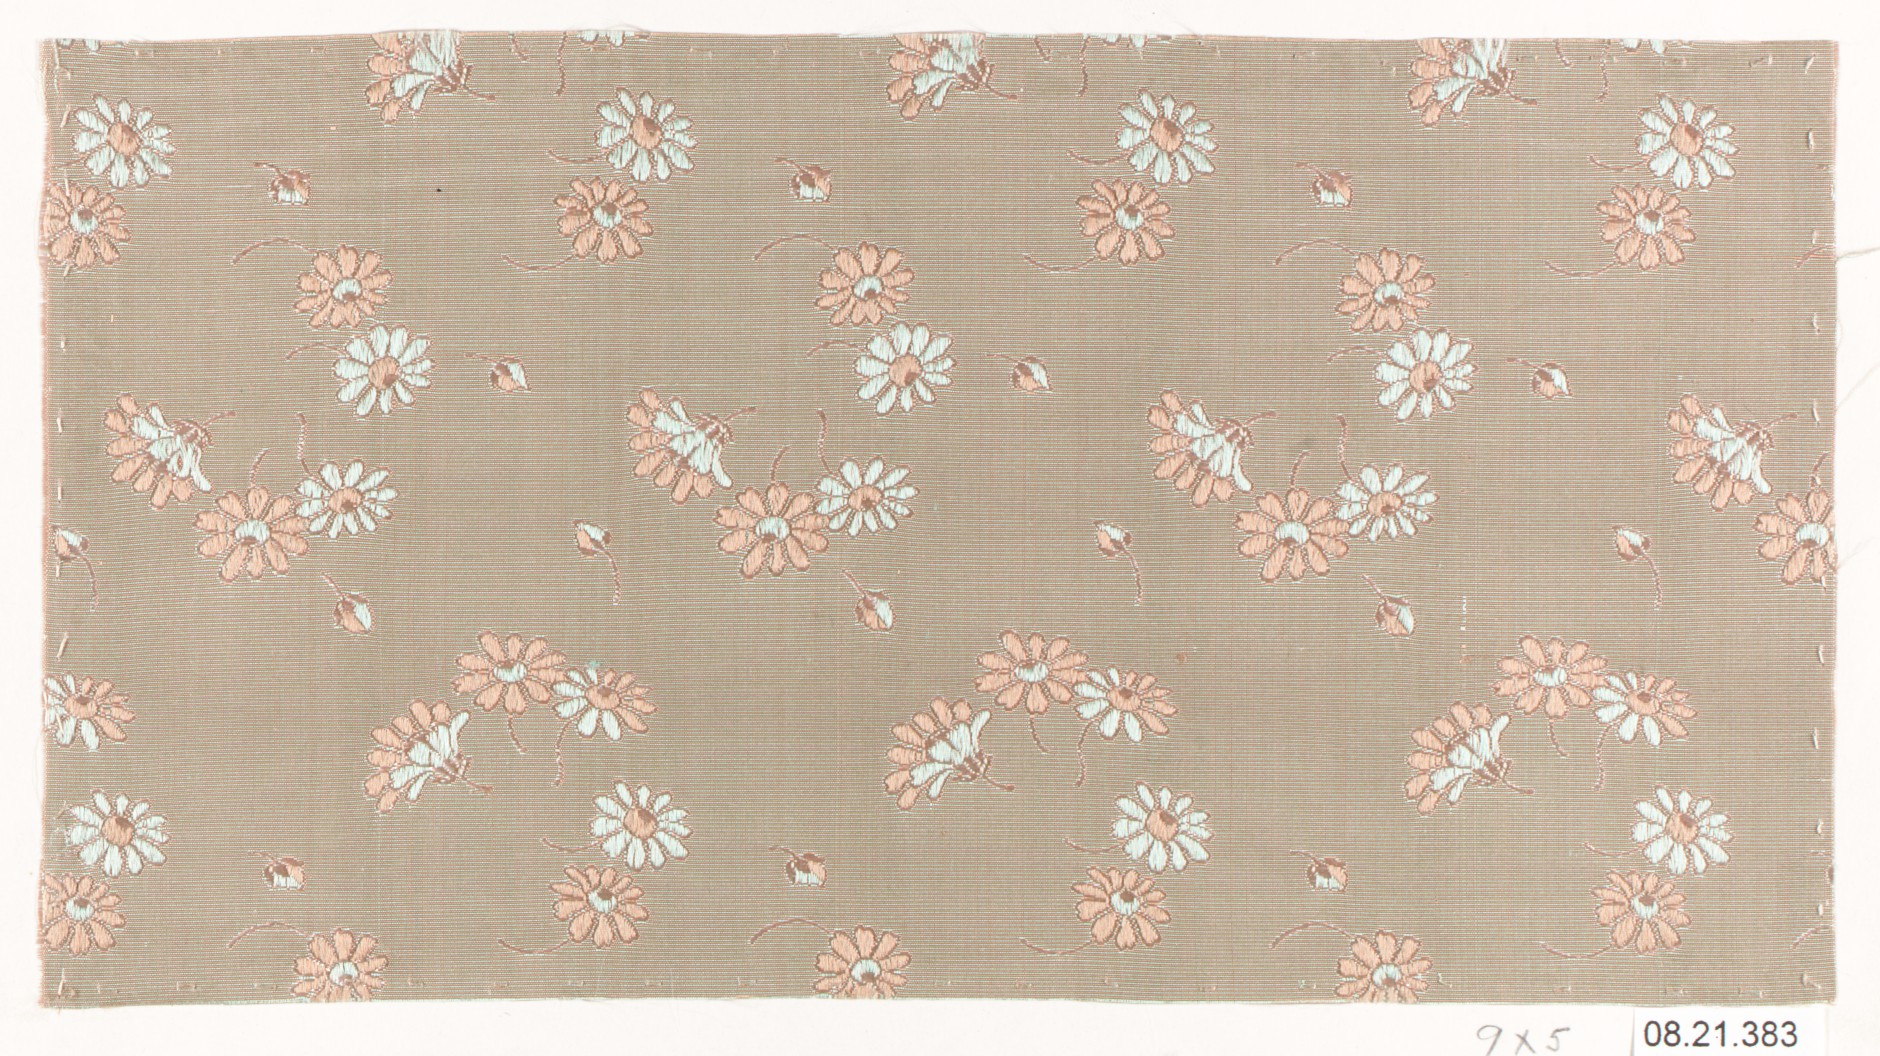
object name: textile sample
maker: Anonymous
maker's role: designer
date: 1900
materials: silk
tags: flowers